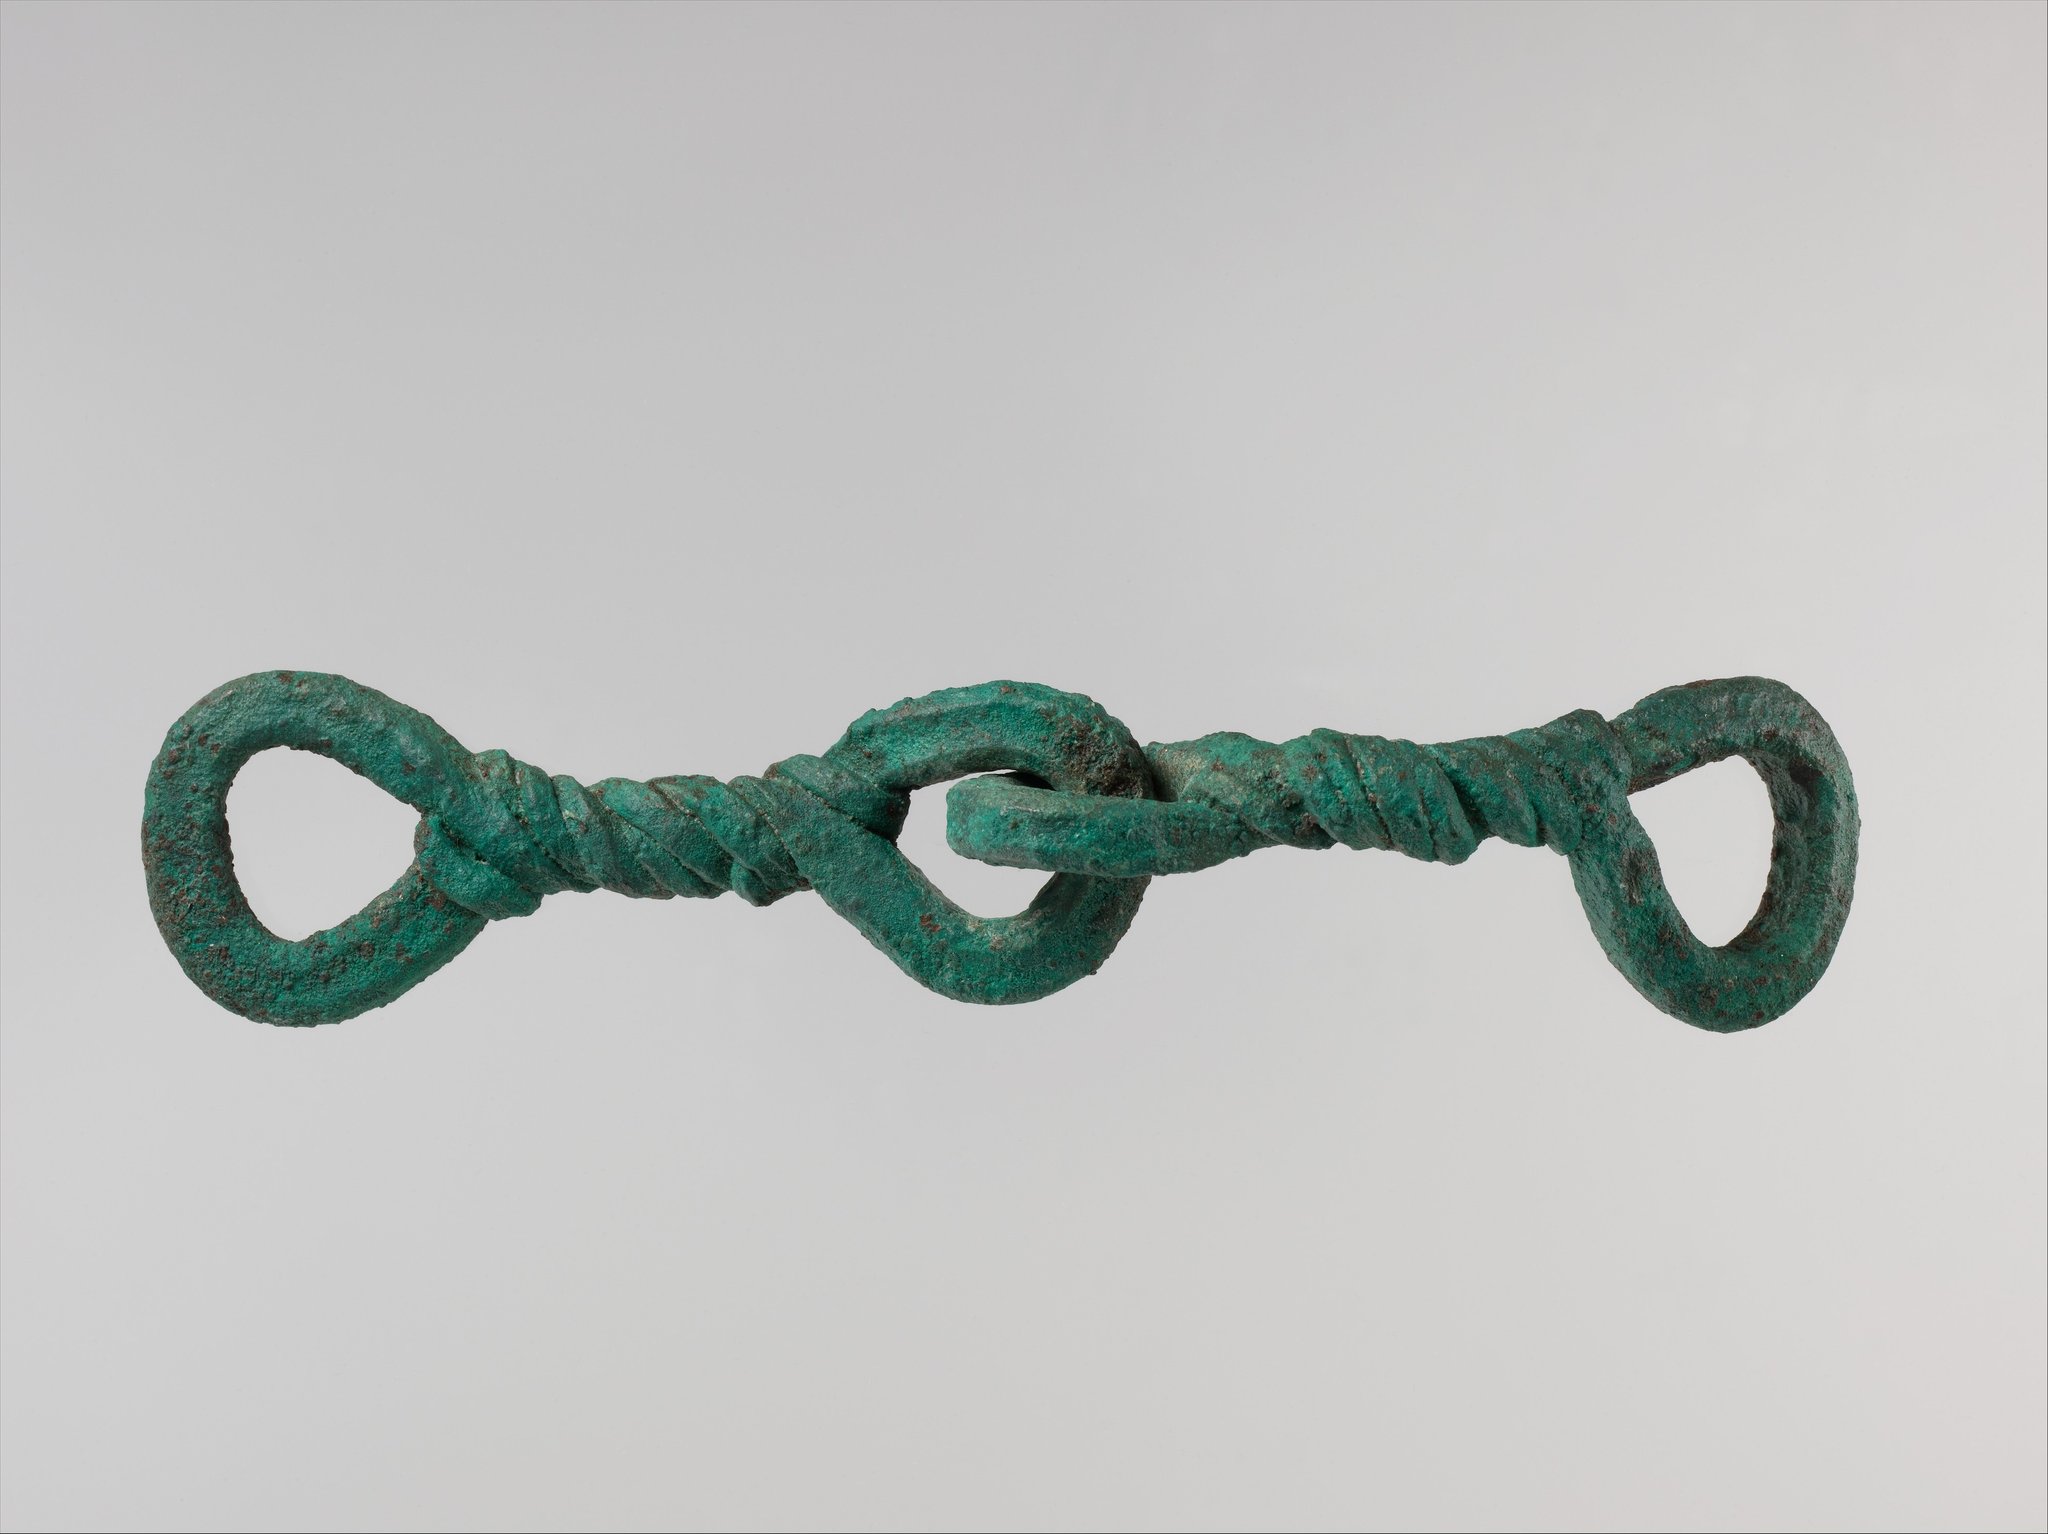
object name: horse bit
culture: iranian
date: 900-801 BCE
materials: bronze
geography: iran